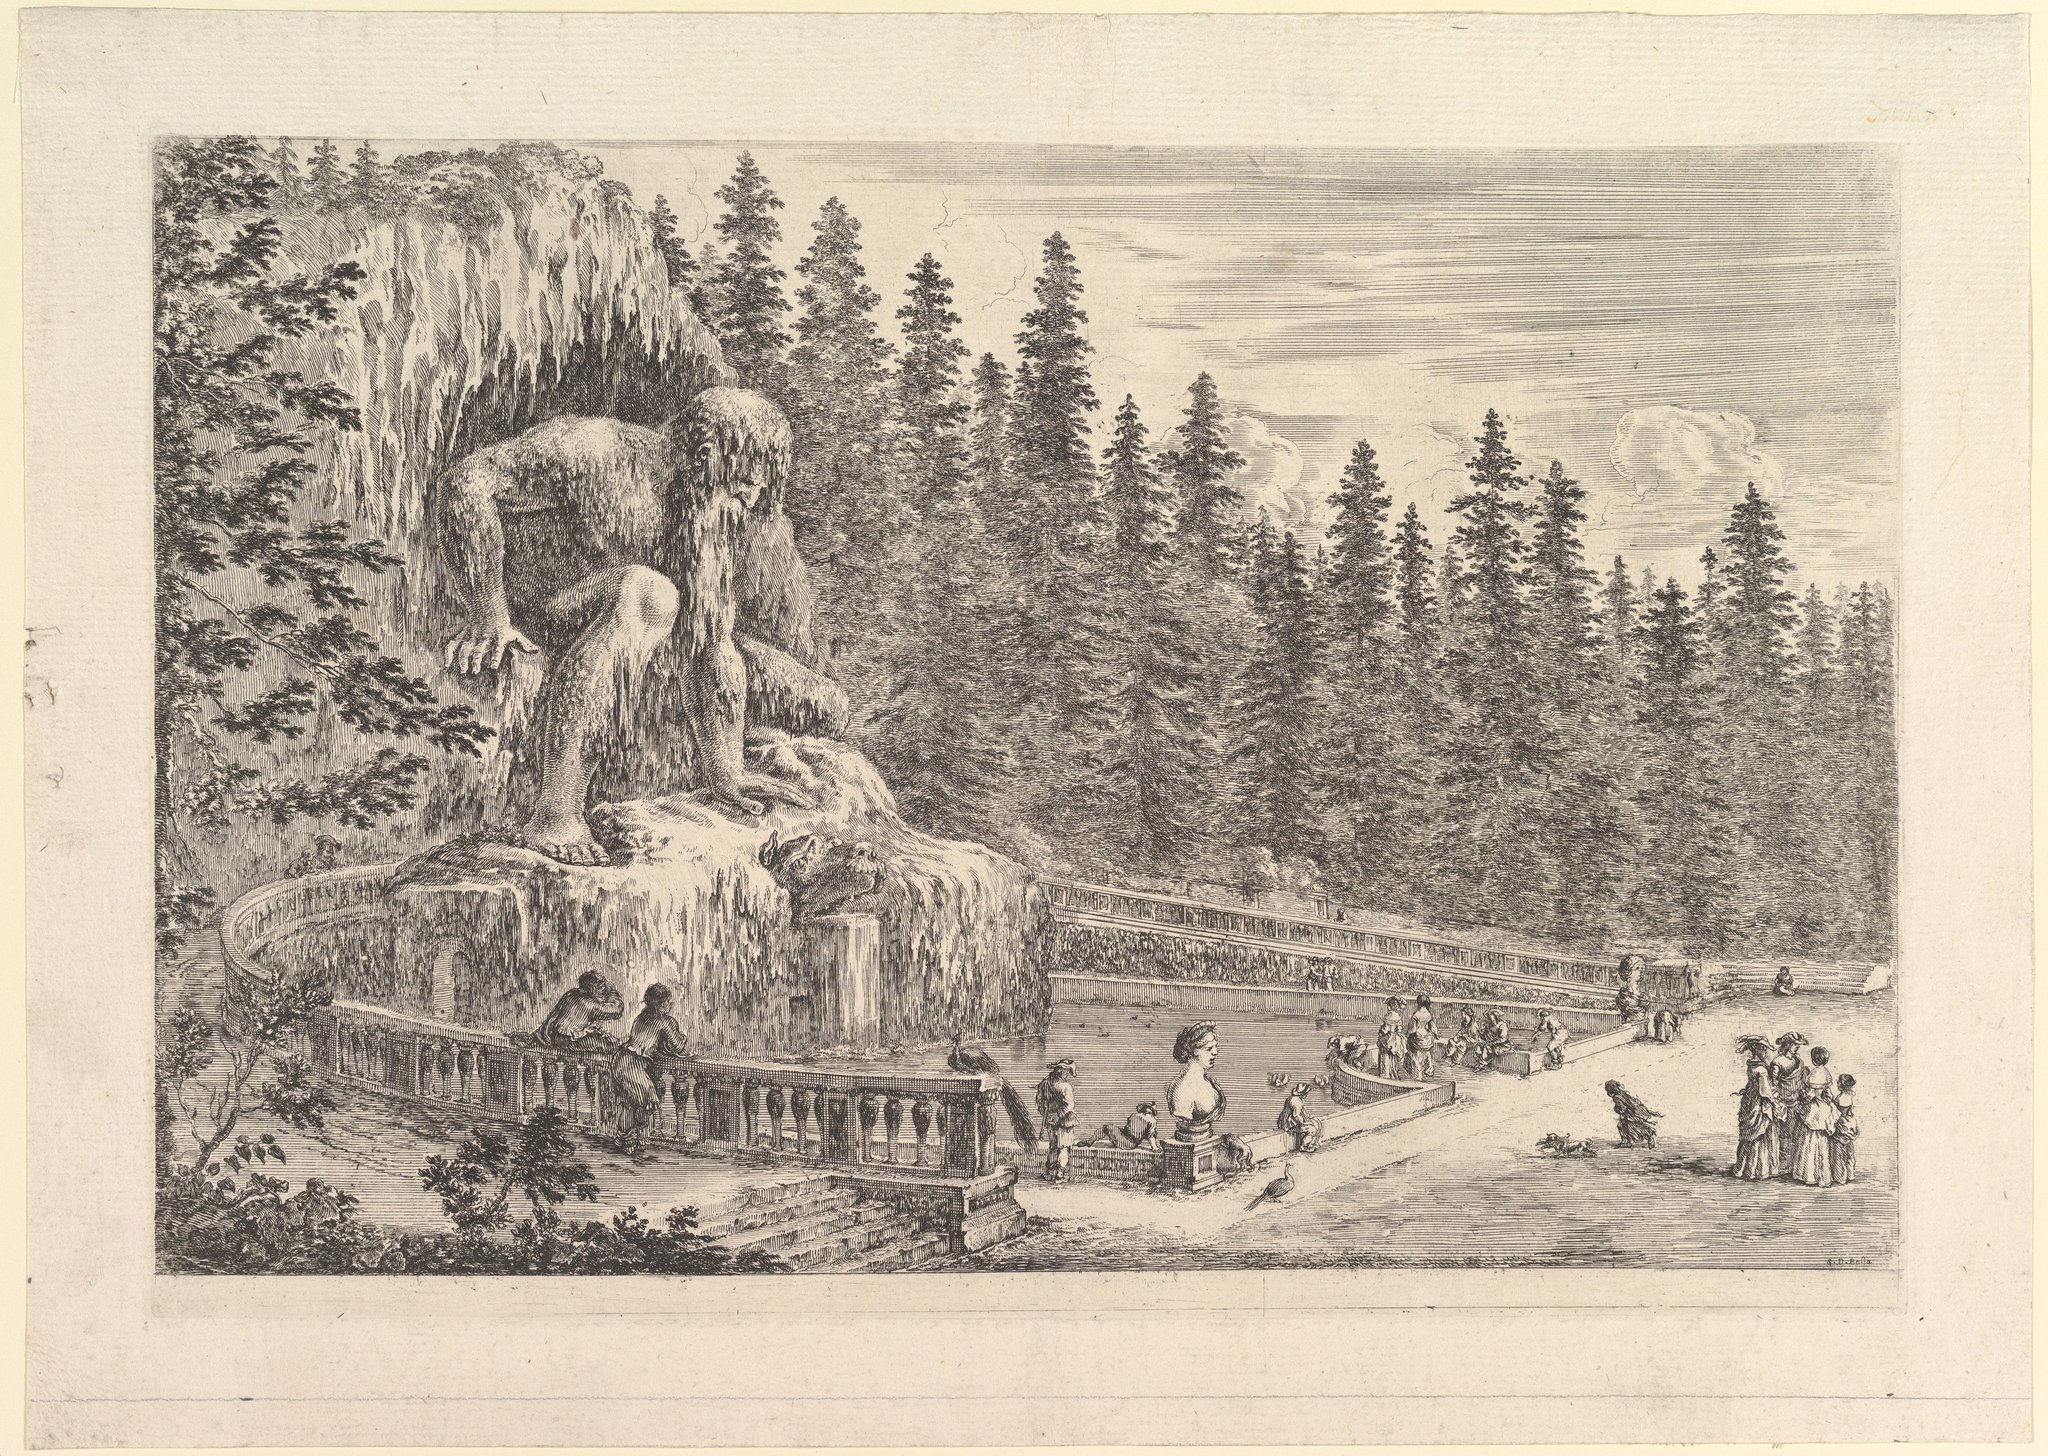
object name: print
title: Colossal statue of the Appenino by Giambologna, from "Views of the villa at Pratolino" (Vues de la villa de Pratolino)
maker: stefano della bella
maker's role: artist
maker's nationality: italian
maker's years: 1610-1664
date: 1653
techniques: etching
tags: sculpture,girls,women,peacocks,trees